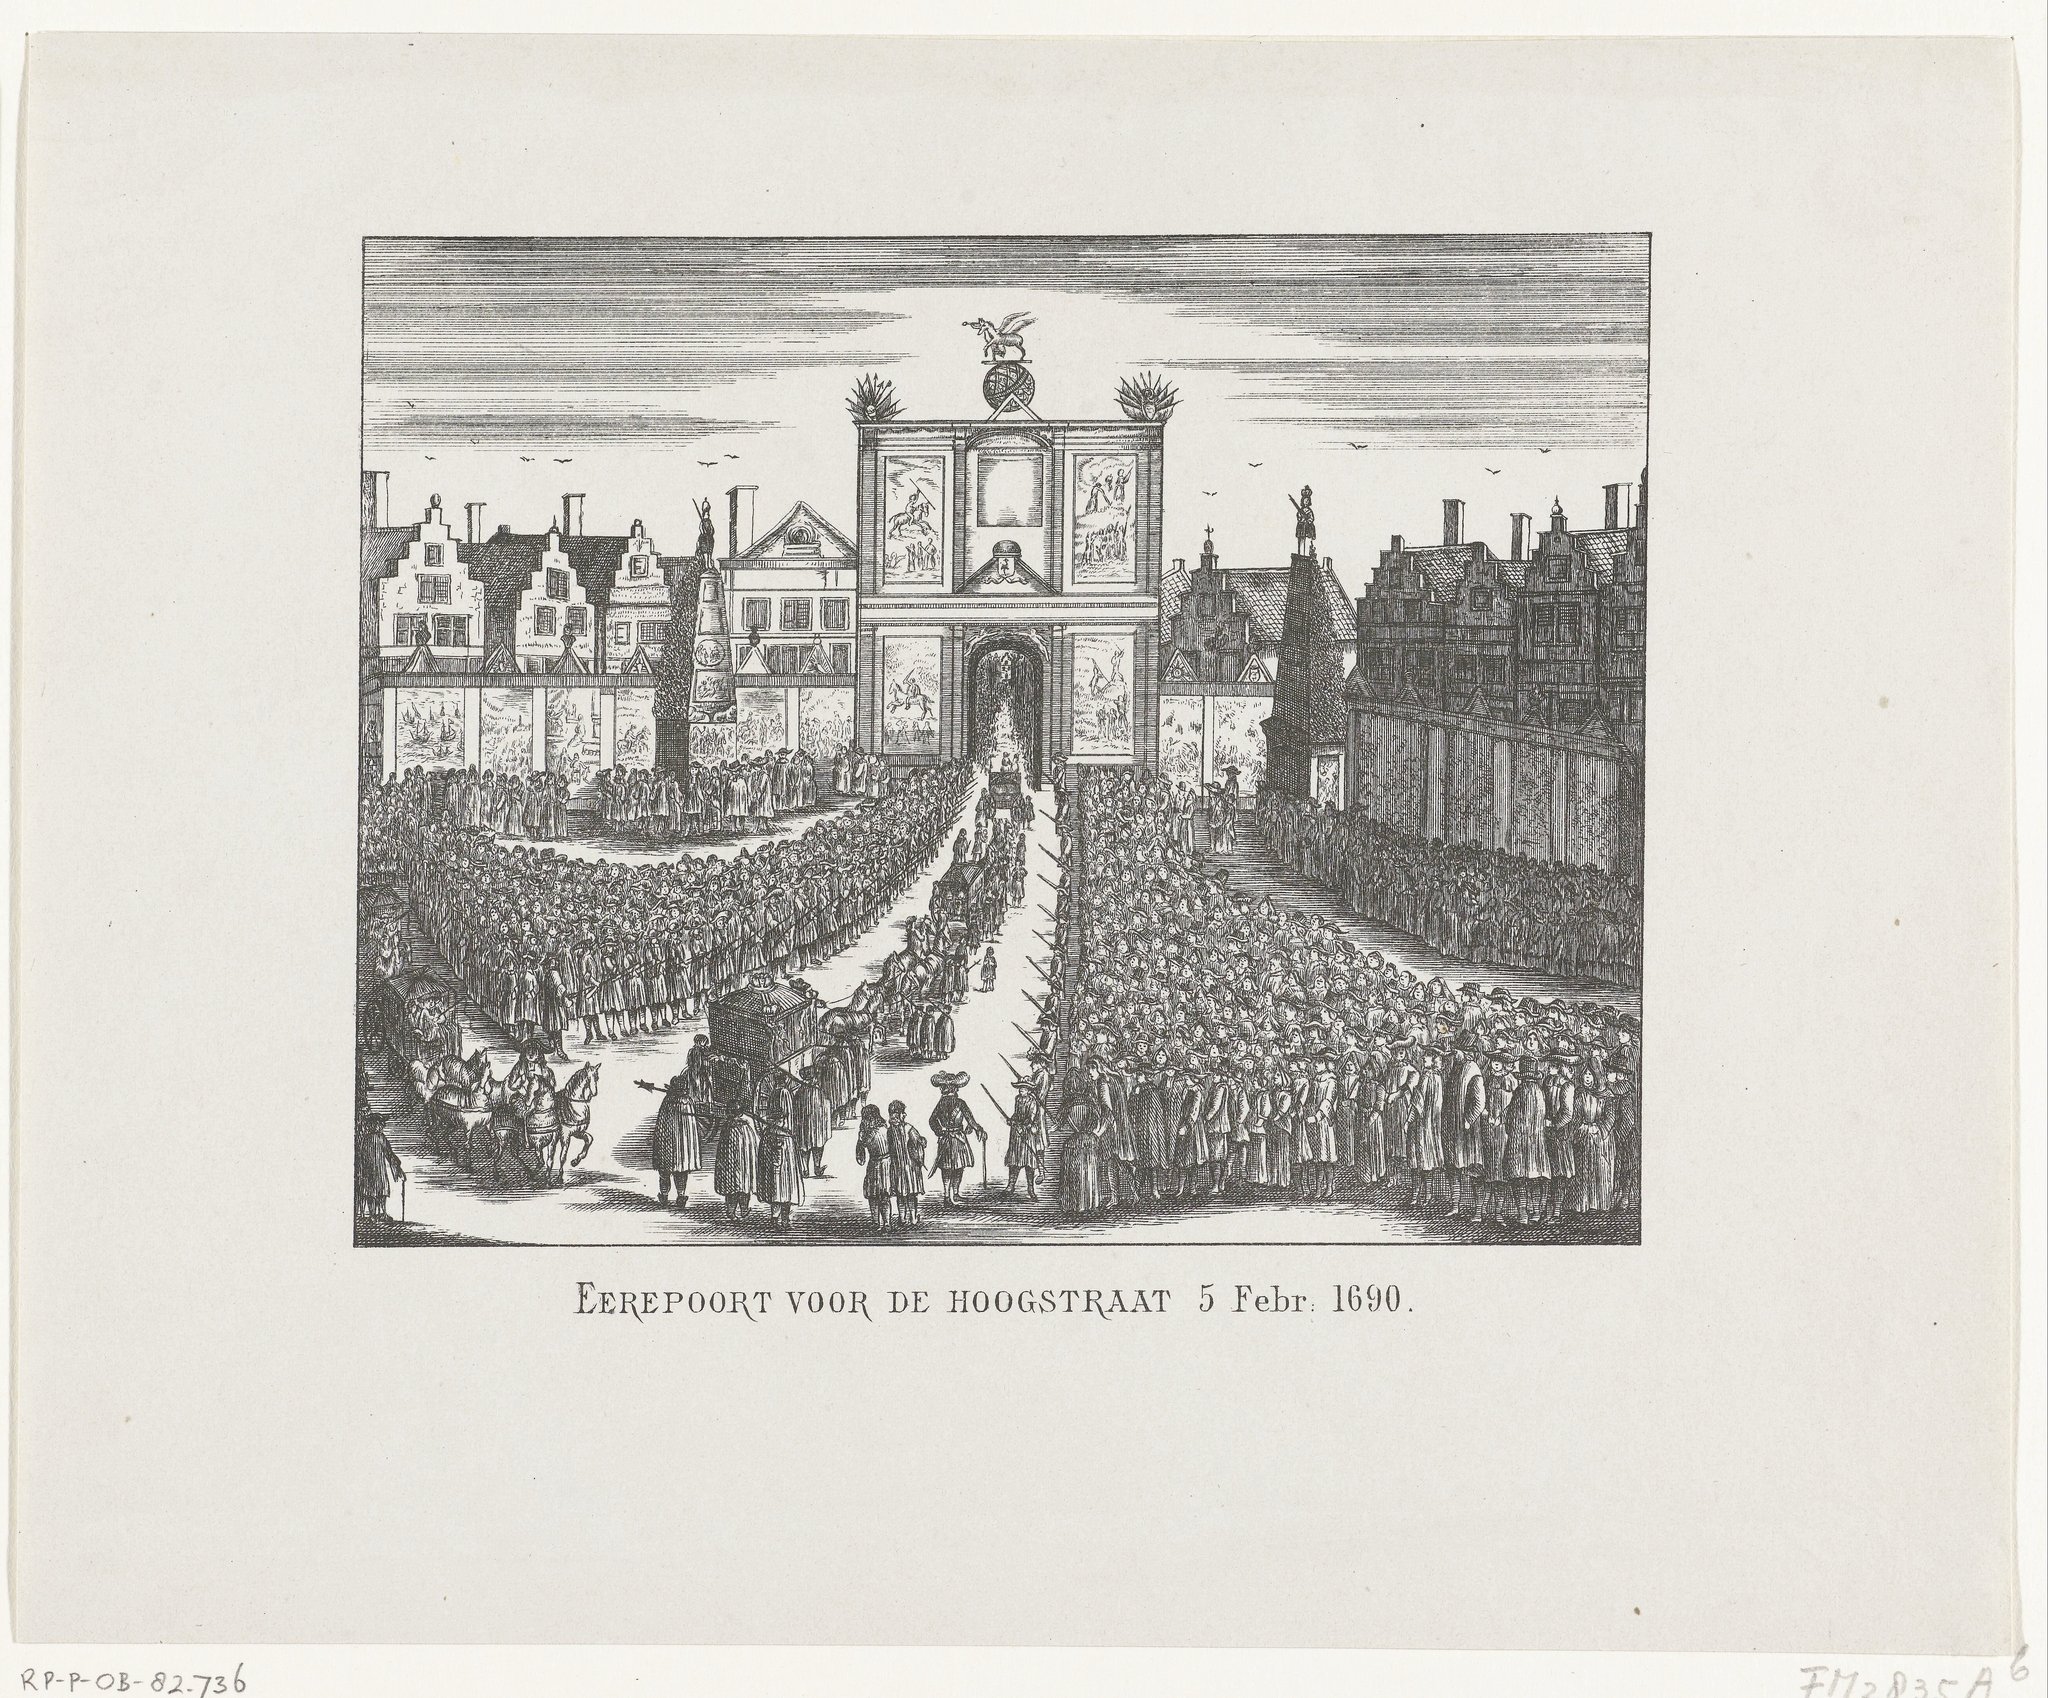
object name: print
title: Eerepoort voor de Hoogstraat 5 Febr. 1690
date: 1877-1879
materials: paper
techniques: lithograph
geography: netherlands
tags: william iii (prince of orange and king of england, scotland, and ireland), triumphal arch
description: Gebruikt als illustratie in: J.P. Arend, Algemeene geschiedenis des vaderlands, voortgezet door O. van Rees, W.G. Brille en J. van Vloten, Amsterdam, 5 delen, 1840-1882, dl. 4.2 (1879), p. 544/545. Voor de oorspronkelijke prent zie FMH 2835Aa/2.